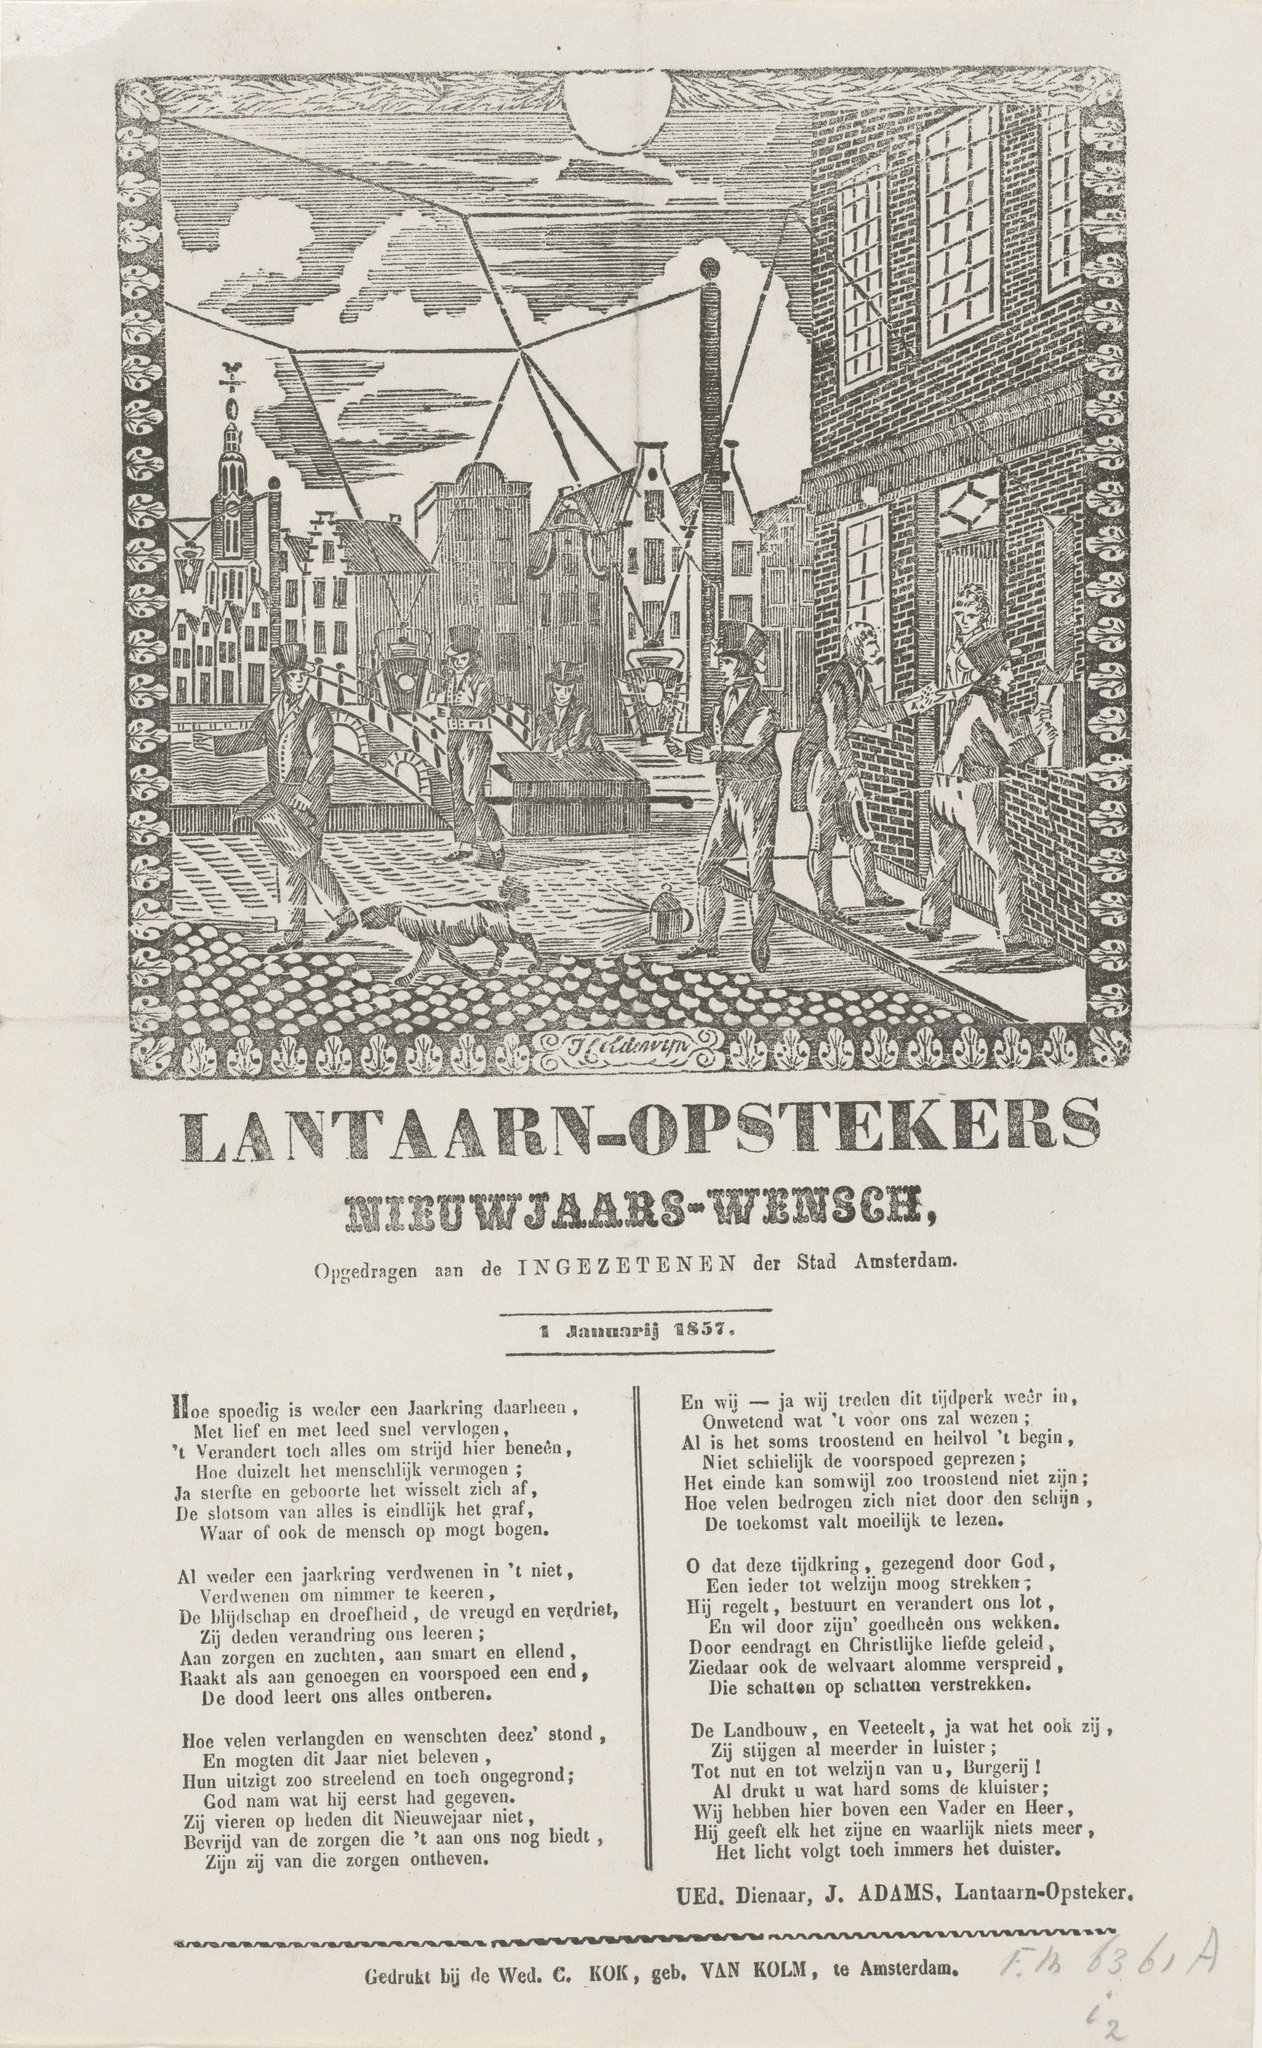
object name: print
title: Nieuwjaarswens van de lantaarnopstekers van Amsterdam voor het jaar 1857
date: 1856-1857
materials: paper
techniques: letterpress printing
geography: amsterdam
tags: oil-lamp (+ kindling a light; lit, burning light, lamp, candle), street lighting, street, amsterdam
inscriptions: collector's mark: Lugt 2228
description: Nieuwjaarswens van de Amsterdamse lantaarnopstekers en vullers voor het jaar 1857. Gezicht in een straat in Amsterdam waar enkele mannen bezig zijn de straatlantaarns te vullen en aan te steken. Een andere man haalt geld op bij een huis. Met gedicht in twee kolommen. Van de lantaarnopsteker: J. Adams.